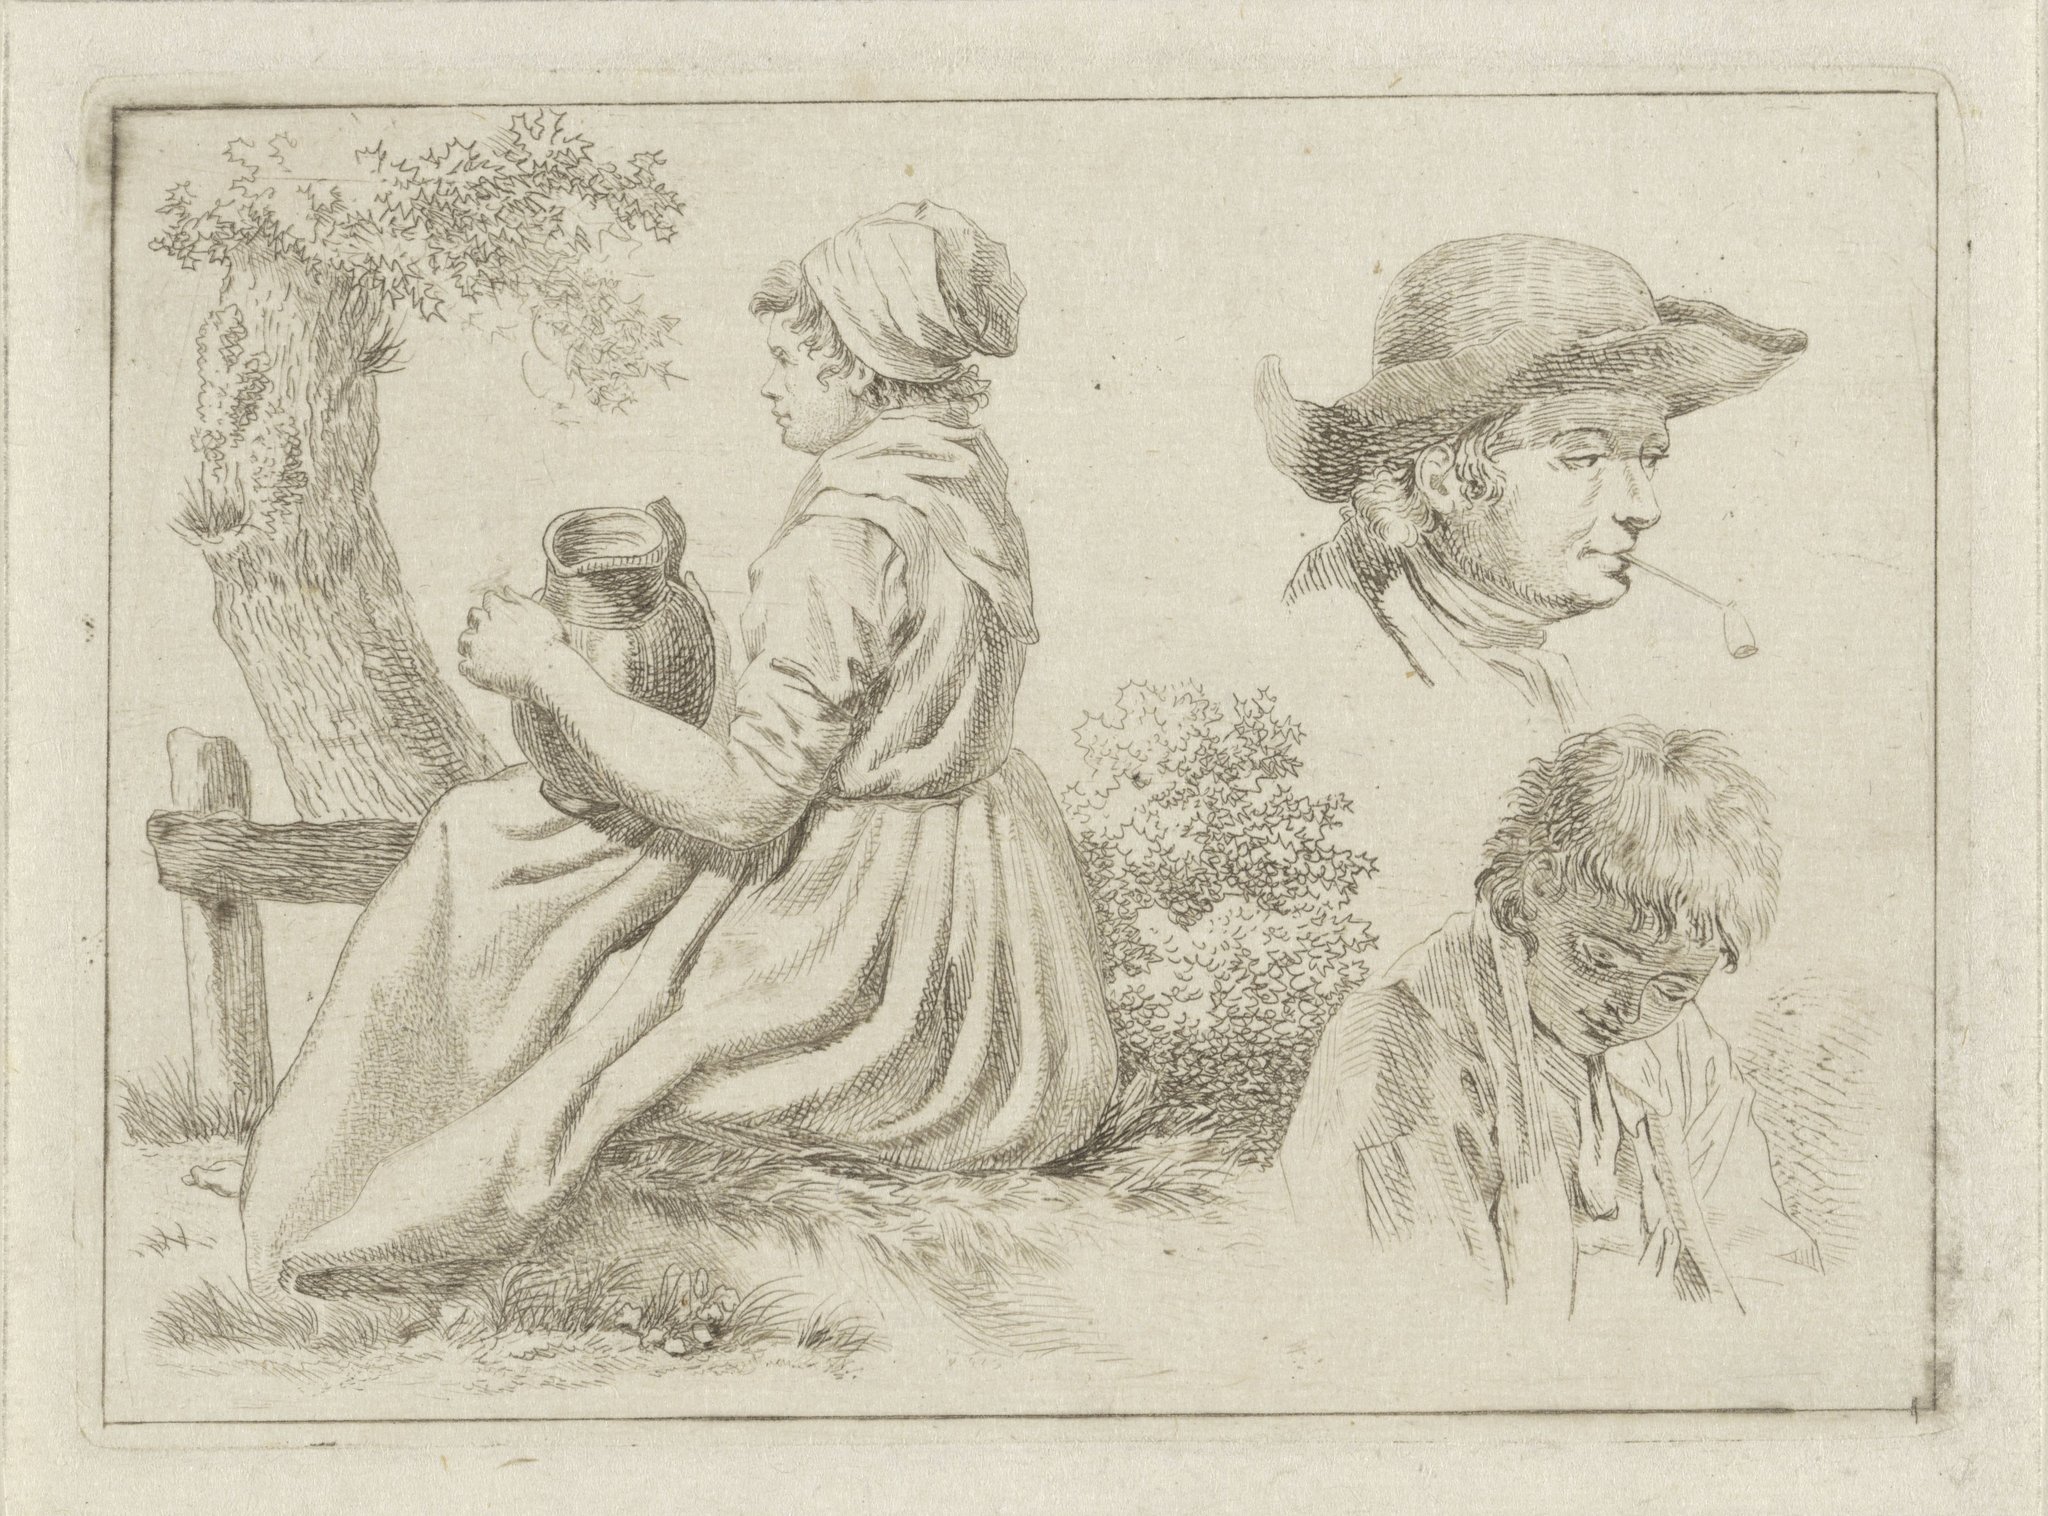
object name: print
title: Zittende vrouw met schenkkan, portret van een man met pijp en een jongen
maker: johan christiaan willem safft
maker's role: draughtsman, print maker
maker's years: 1778-1849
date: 1788-1849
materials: paper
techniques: etching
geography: amsterdam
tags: pipe ~ tobacco, jar, jug (used as drinking-vessel), head-gear: hat (+ women's clothes)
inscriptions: collector's mark: Lugt 2228